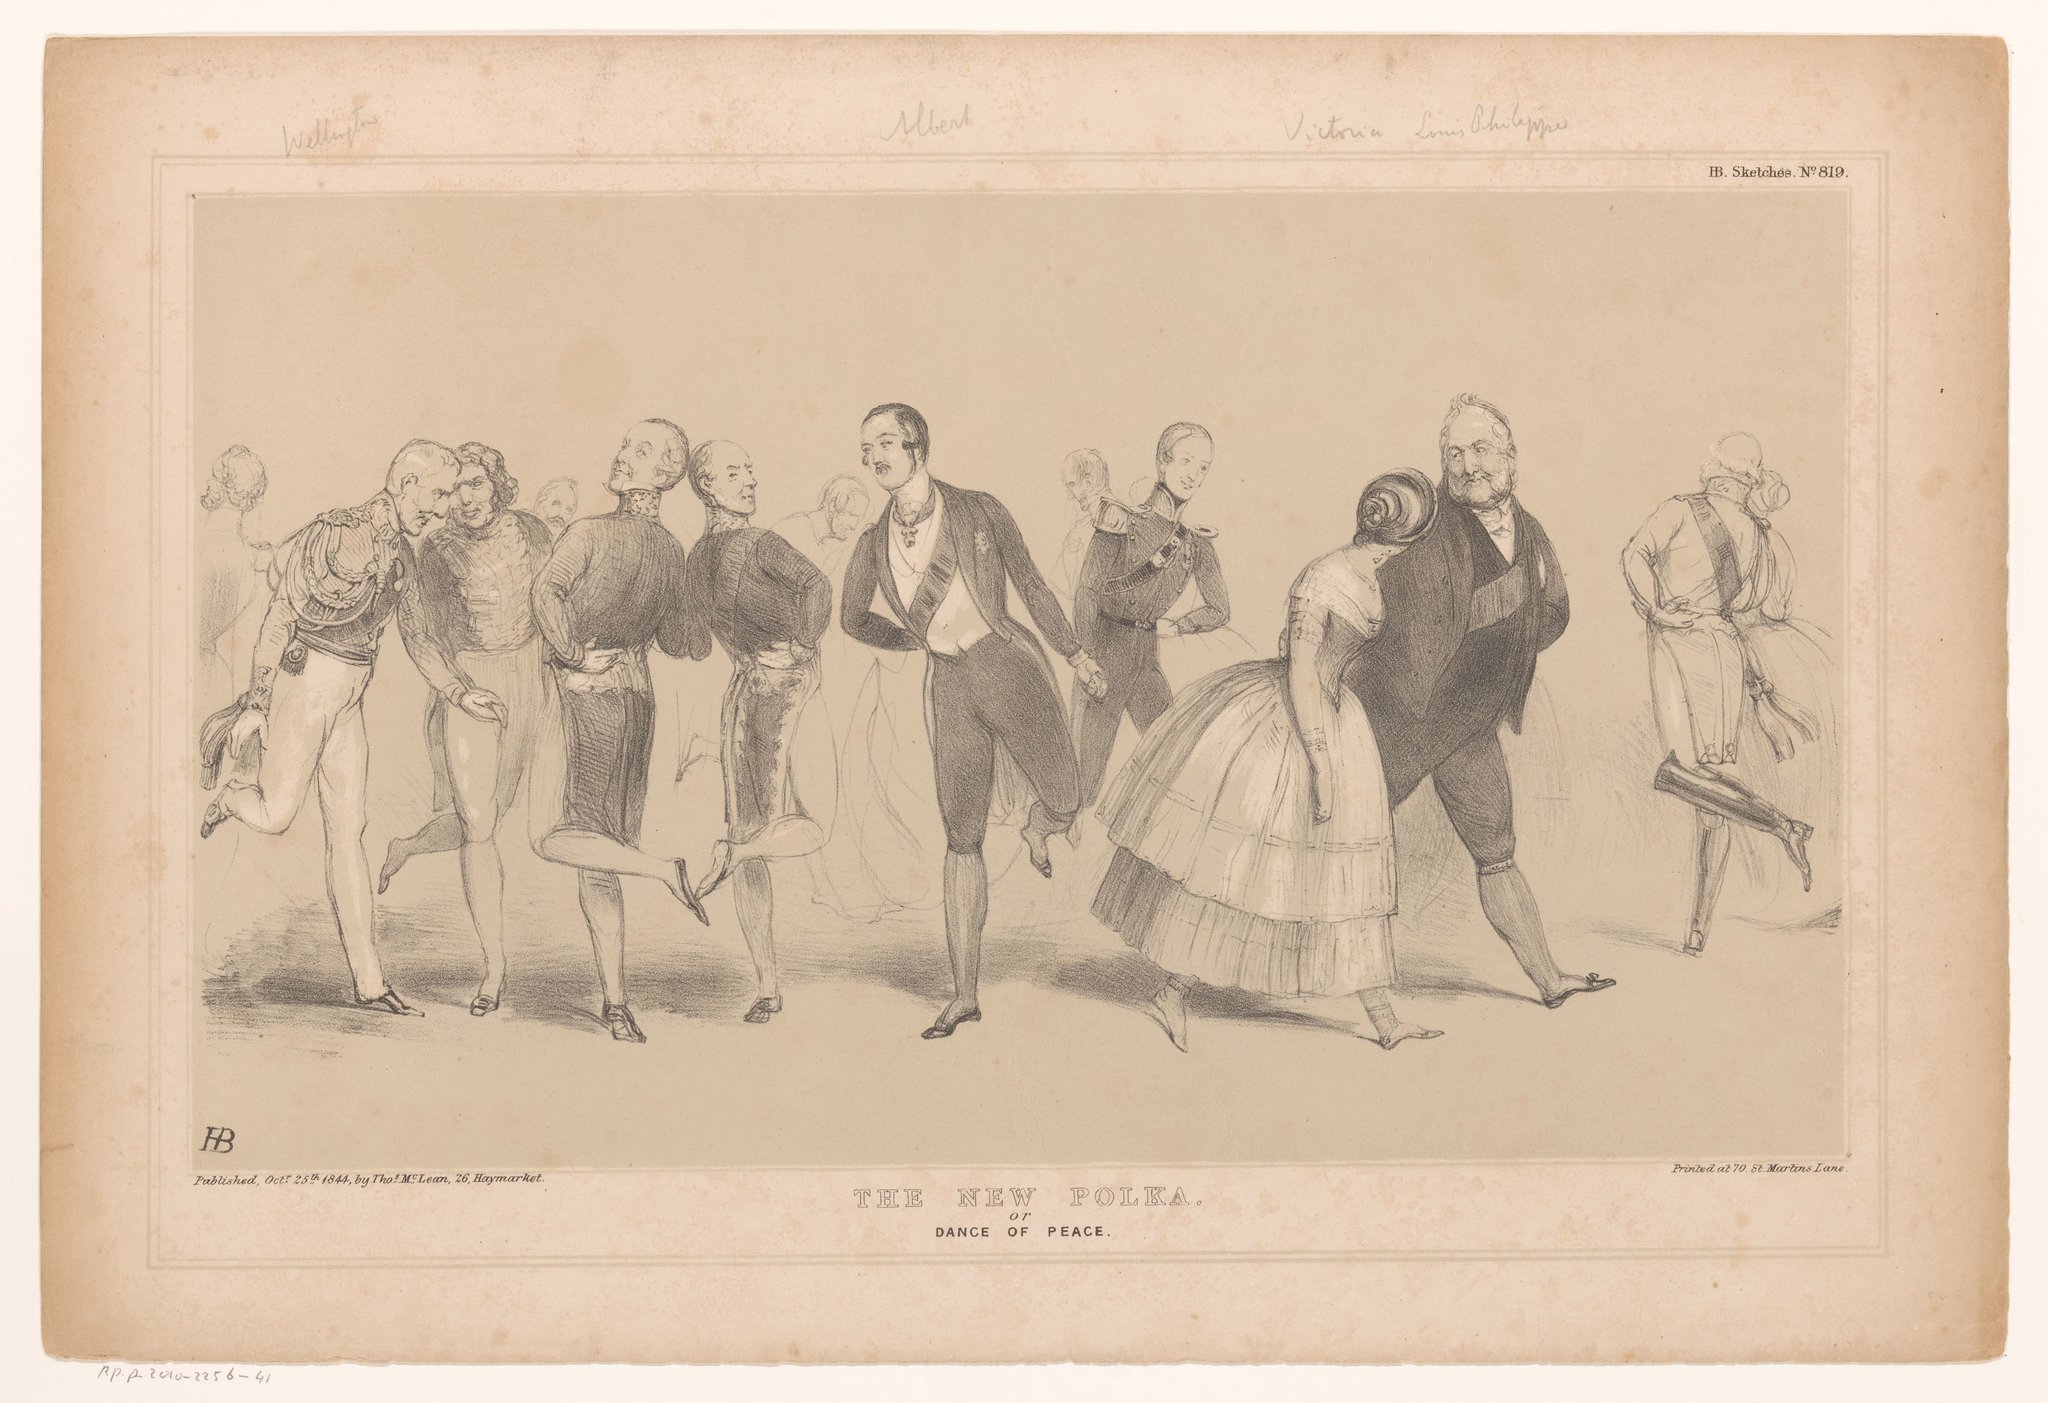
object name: print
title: Koningin Victoria en Koning Lodewijk Filips dansen de vredesdans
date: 1844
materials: paper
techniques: tone lithography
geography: london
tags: victoria (koningin van het verenigd koninkrijk en keizerin van india), london, walmer castle, arthur wellesley of wellington, paris, lodewijk filips i (koning van frankrijk), ball, formal dance, political caricatures and satires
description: Spotprent uit 1844 waarin koningin Victoria en de Franse koning Louis Philippe samen de nieuwe polka, de vredesdans, dansen. Links Peel en Wellington. Uitgegeven als nr. 819 in de serie HB Sketches.